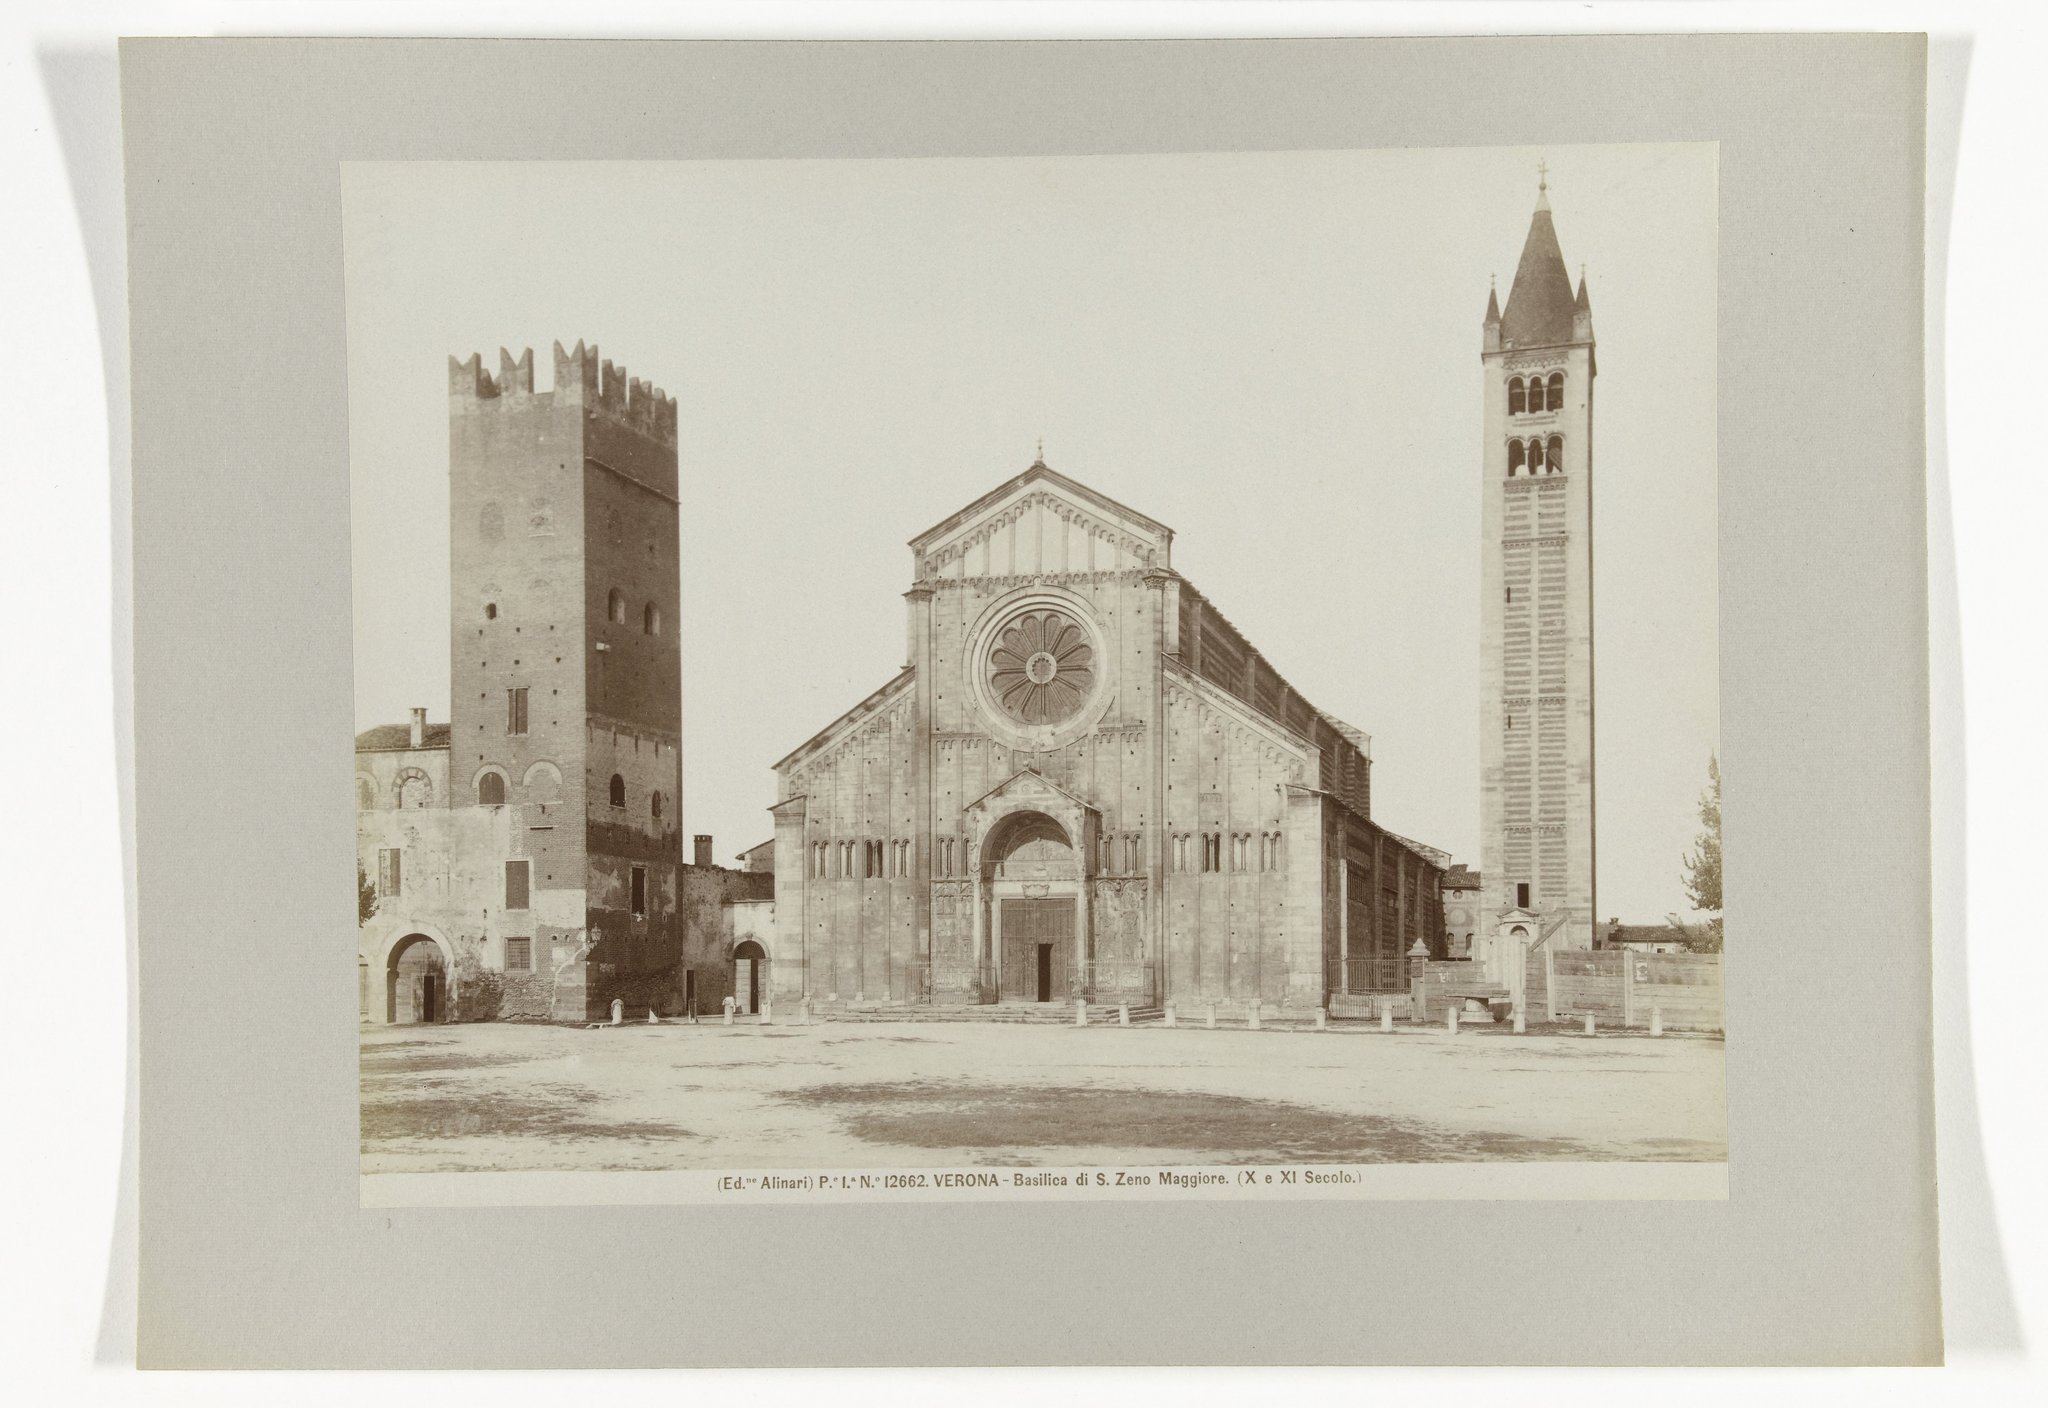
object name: photograph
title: P.e 1.a N.o 12662. VERONA - Basilica di S. Zeno Maggiore. (X e XI Secolo.)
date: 1880-1895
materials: cardboard, paper, photographic support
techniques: albumen print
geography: florence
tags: church (exterior), tower (of house or building)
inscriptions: number: ‘85.’